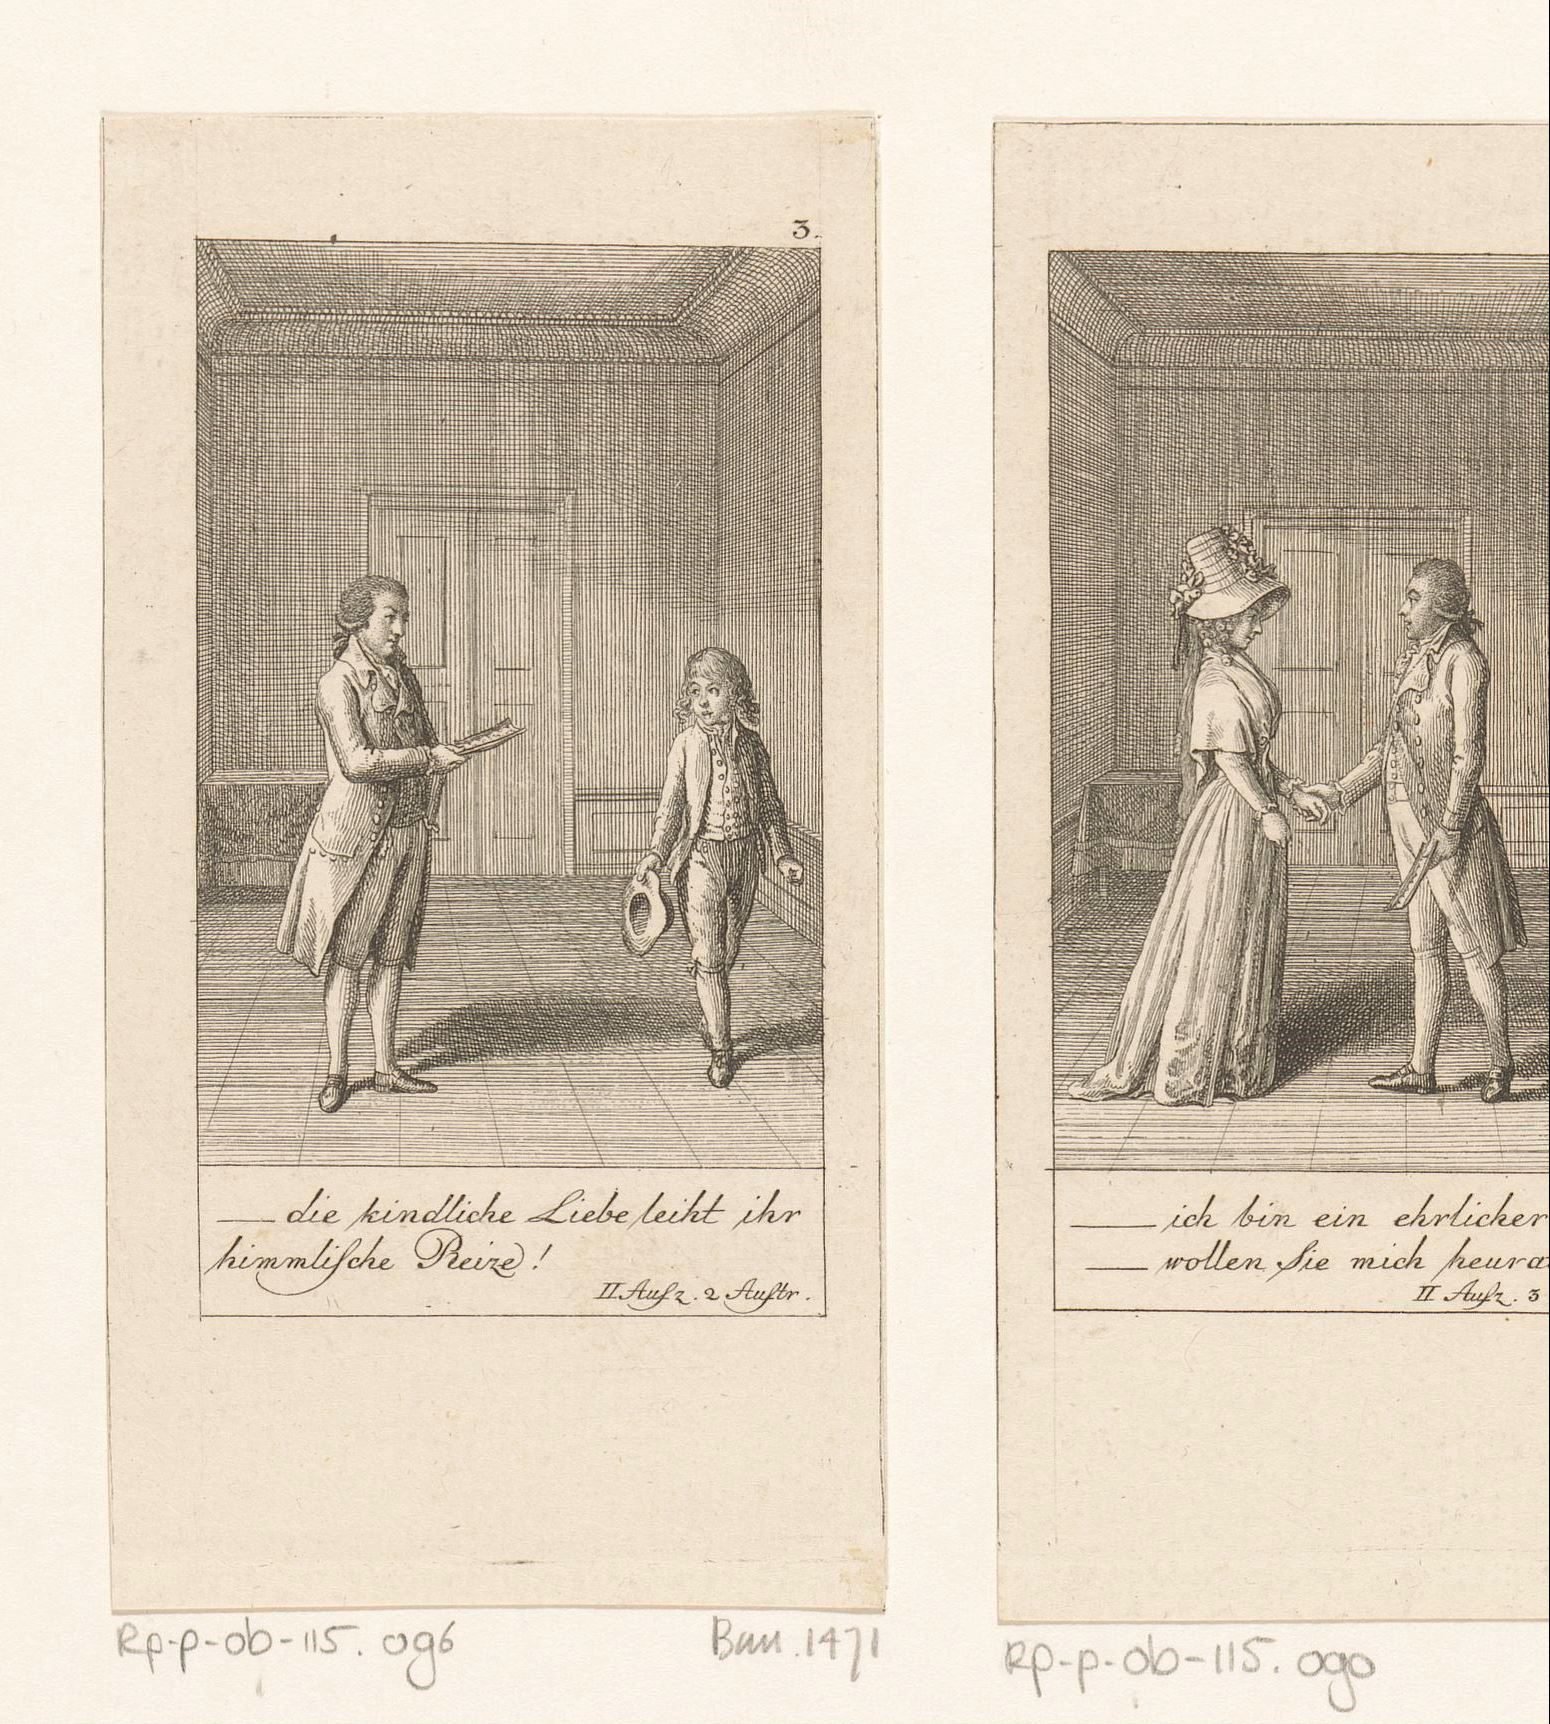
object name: book illustration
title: Kaberdar koopt de manchetknopen van de jongeman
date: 1790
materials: paper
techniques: etching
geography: lauenburg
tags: literature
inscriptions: collector's mark: Lugt 2228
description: Vervaardigd voor 'De Indianen in Engeland' van August von Kotzebue. Prent gebruikt in: Königl. Grosbritannischer Historischer Genealogischer Calender für 1791. Lauenburg: Berenberg, [1790].